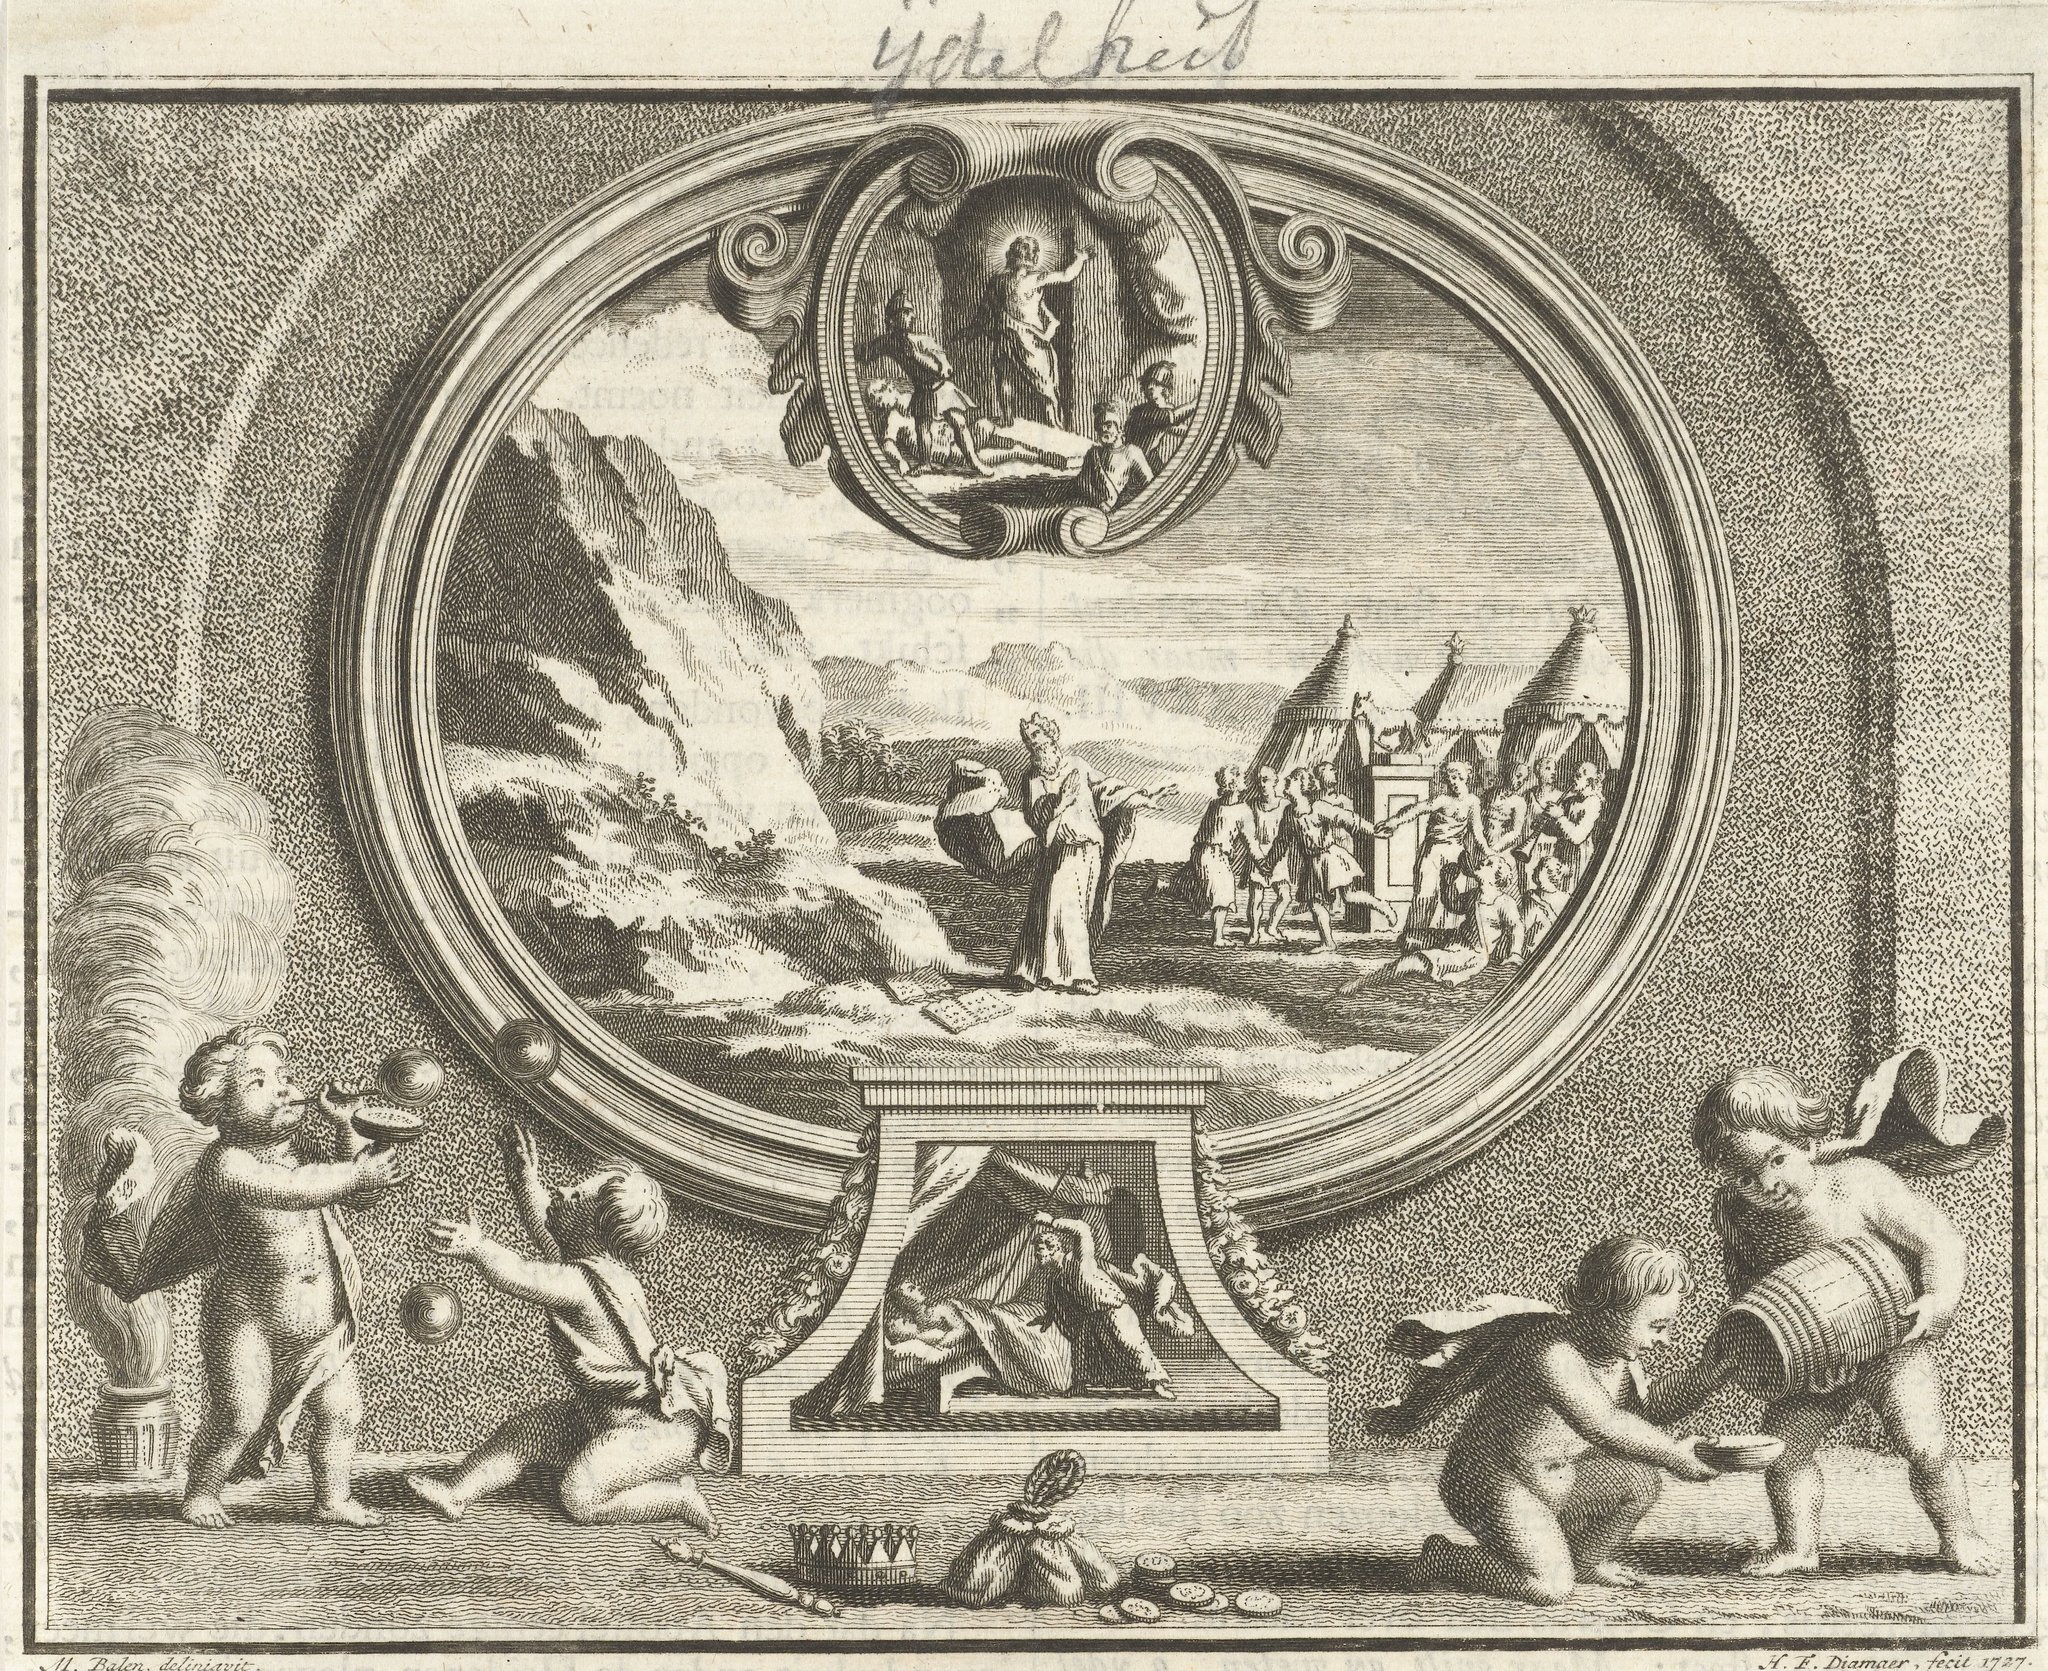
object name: print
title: Allegorie op ijdelheid met dans om het gouden kalf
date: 1727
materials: paper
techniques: engraving, etching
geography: southern netherlands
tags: (children or putti) blowing bubbles, 'homo bulla' ~ scene symbolizing 'vanitas', the people dance around the golden calf ~ exodus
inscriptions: date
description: Allegorie op ijdelheid met dans om het gouden kalf in ovaal en verwijzing naar de vergankelijkheid met twee kinderen die bellen blazen. Op verso Nederlandse tekst in twee kolommen in boekdruk.